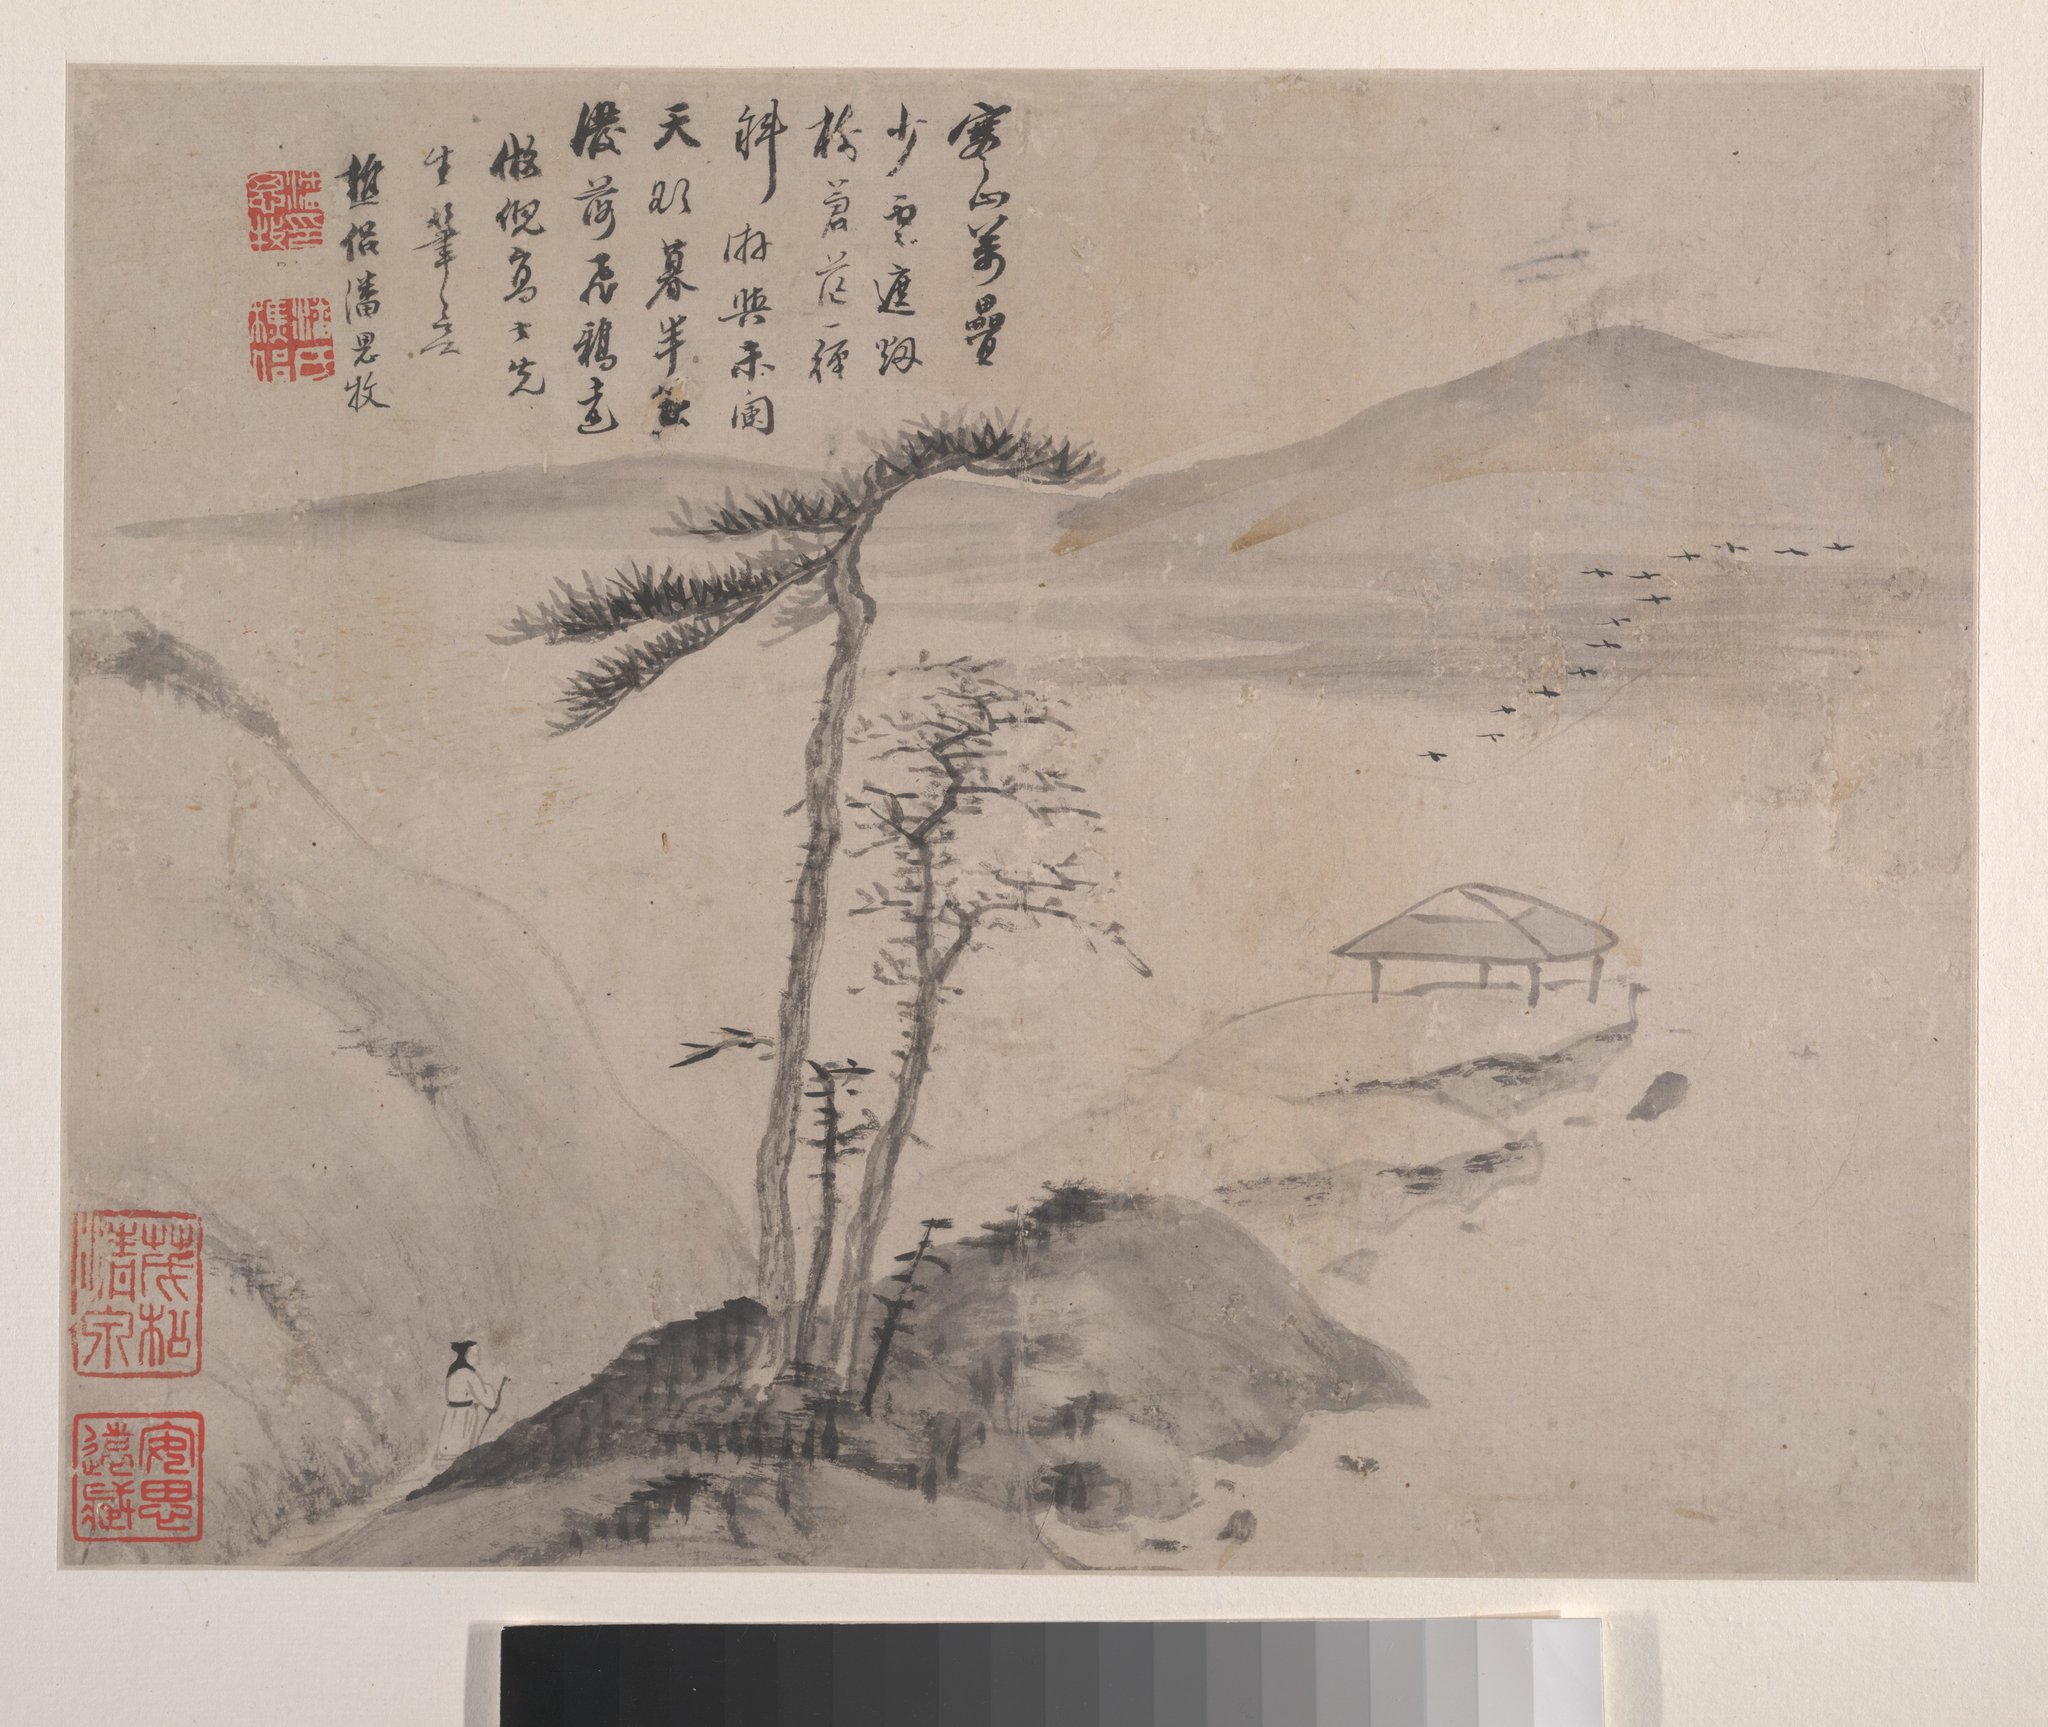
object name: album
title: Landscapes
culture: chinese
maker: pan simu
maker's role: artist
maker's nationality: chinese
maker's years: 1756-1842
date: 1801-1900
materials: ink, paper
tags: landscapes,trees,pavilions